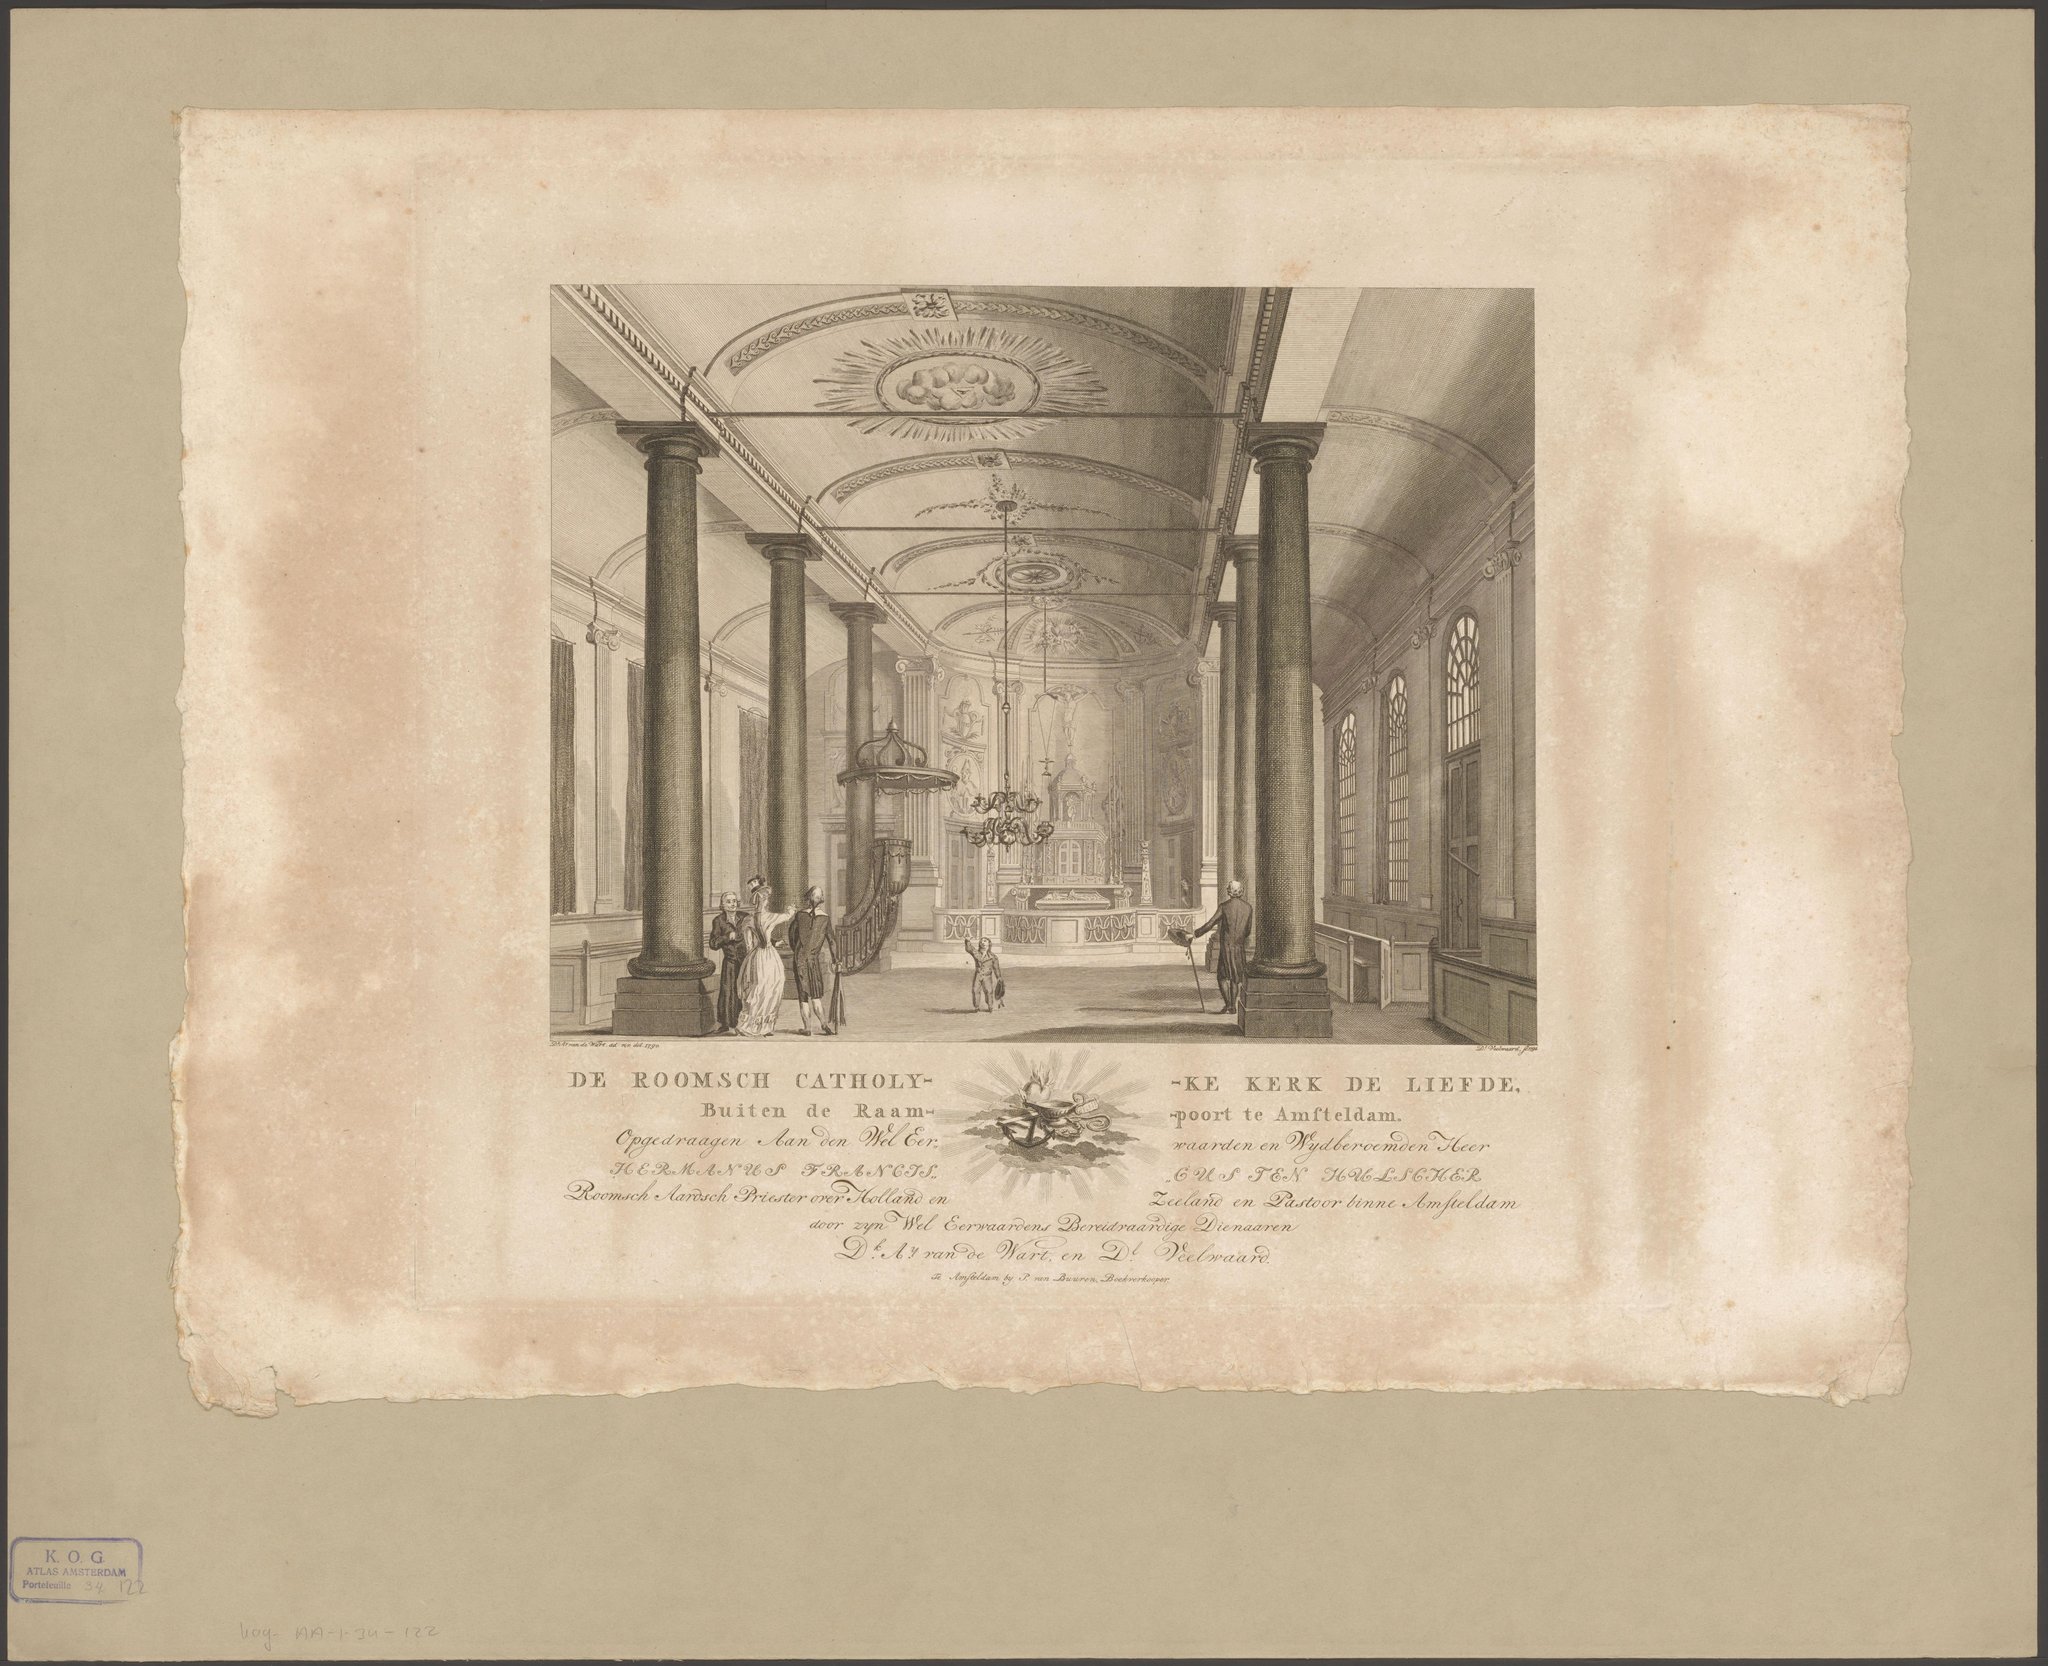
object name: print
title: De Roomsch Catholyke Kerk De Liefde, Buiten de Raampoort te Amsteldam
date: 1791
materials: paper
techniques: engraving, etching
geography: amsterdam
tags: interior of church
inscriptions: collector's mark: Lugt 1641b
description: Onderwerpsrubriek binnen de Atlas Amsterdam: Kerkwezen: R.K. Gemeenten: Begijnhof t/m Petrus en Paulus.